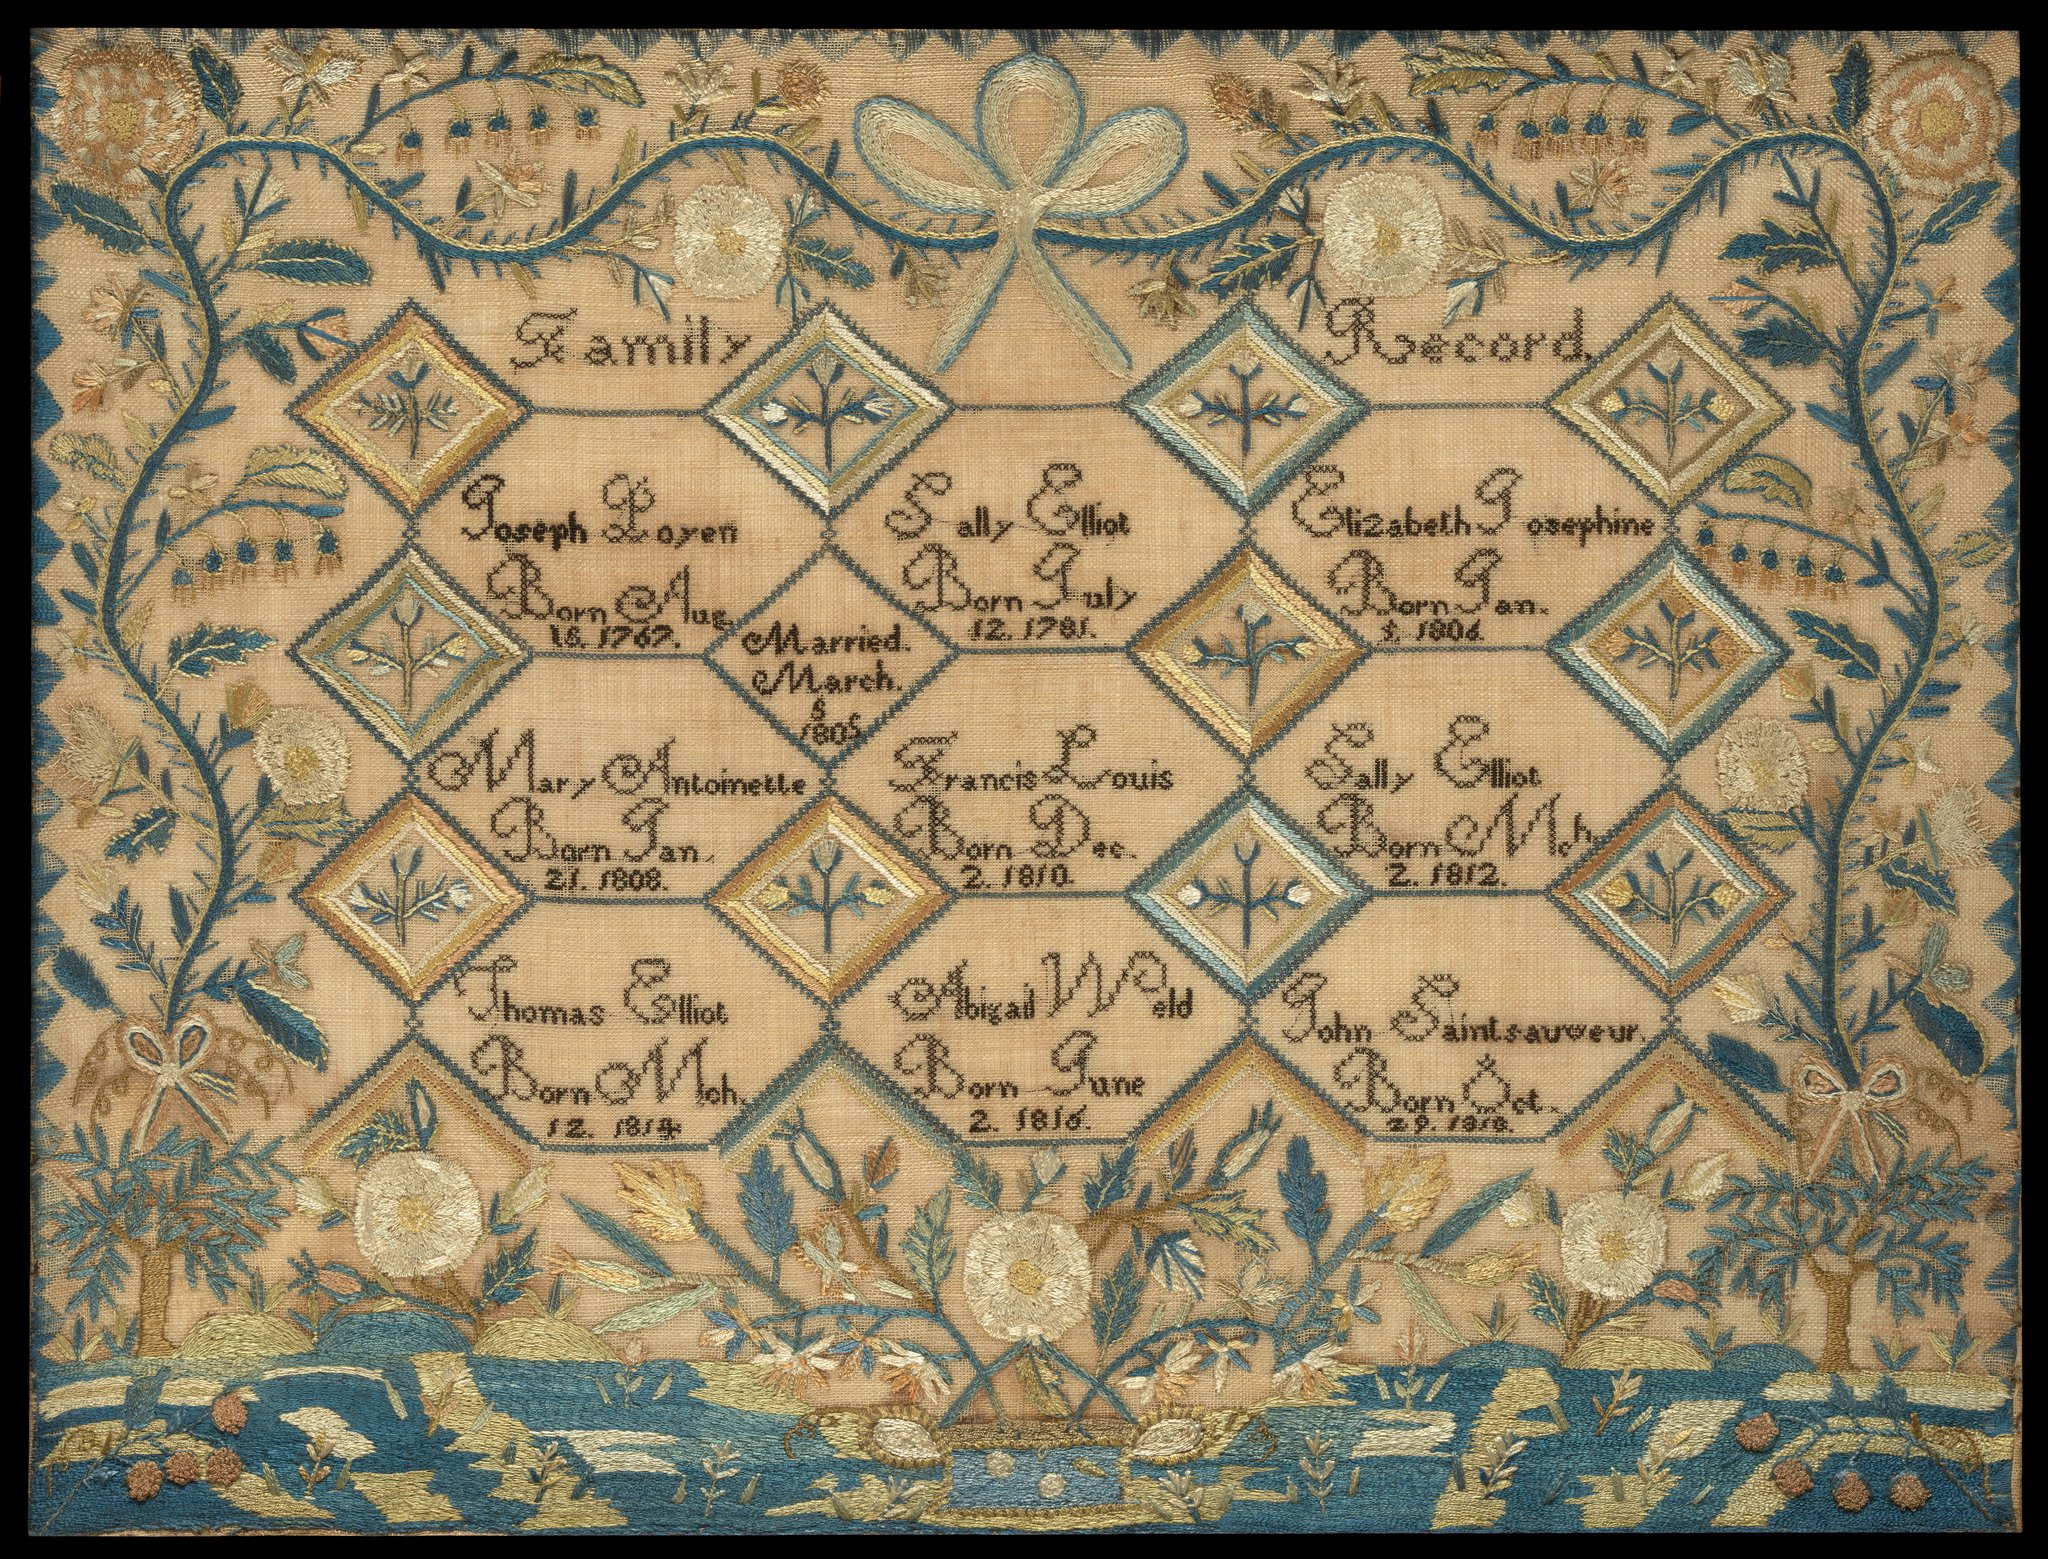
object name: sampler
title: Poyen Family Record Sampler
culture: american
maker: elizabeth josephine poyen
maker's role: maker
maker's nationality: american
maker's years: 1806-1868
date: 1819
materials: linen, silk